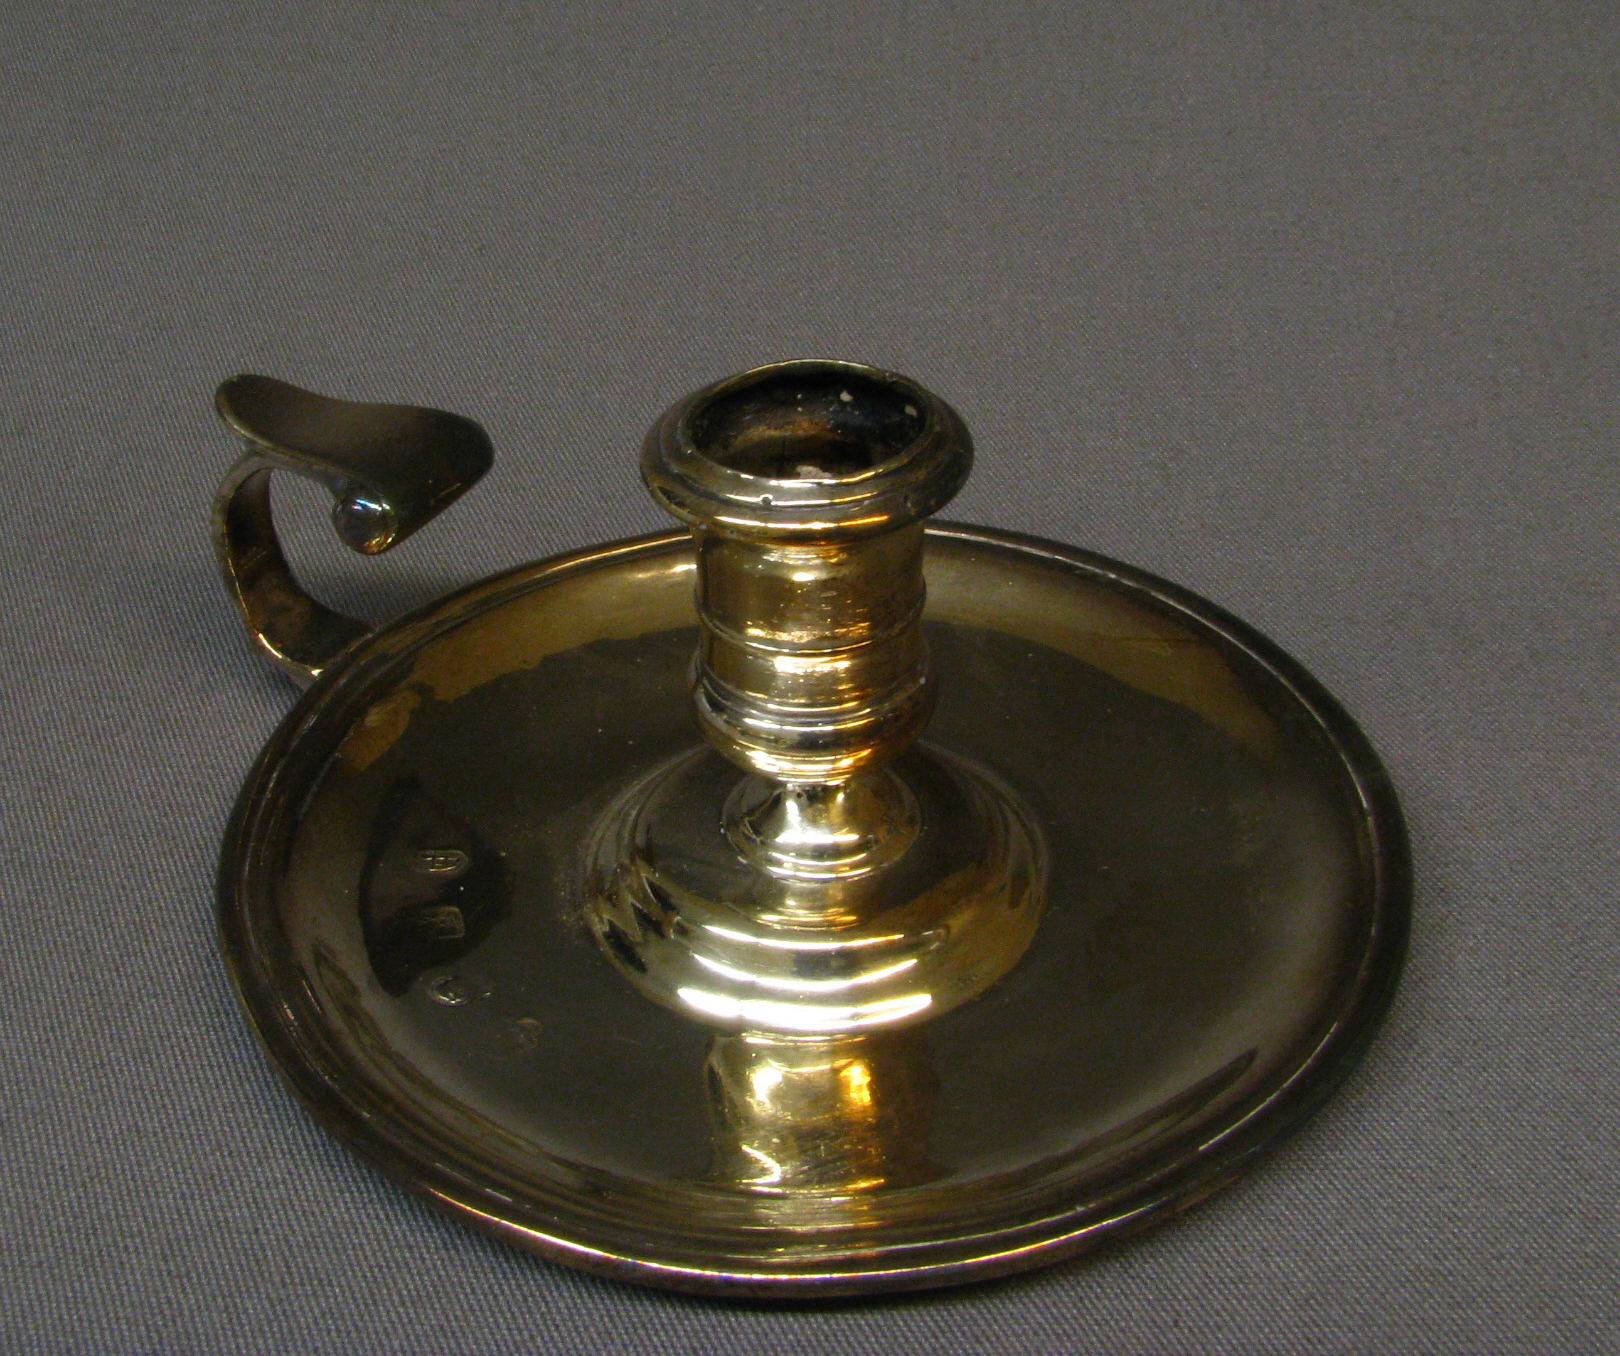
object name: chamber candlestick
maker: joseph bird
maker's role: maker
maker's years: 1635-1735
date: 1714-1715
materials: silver